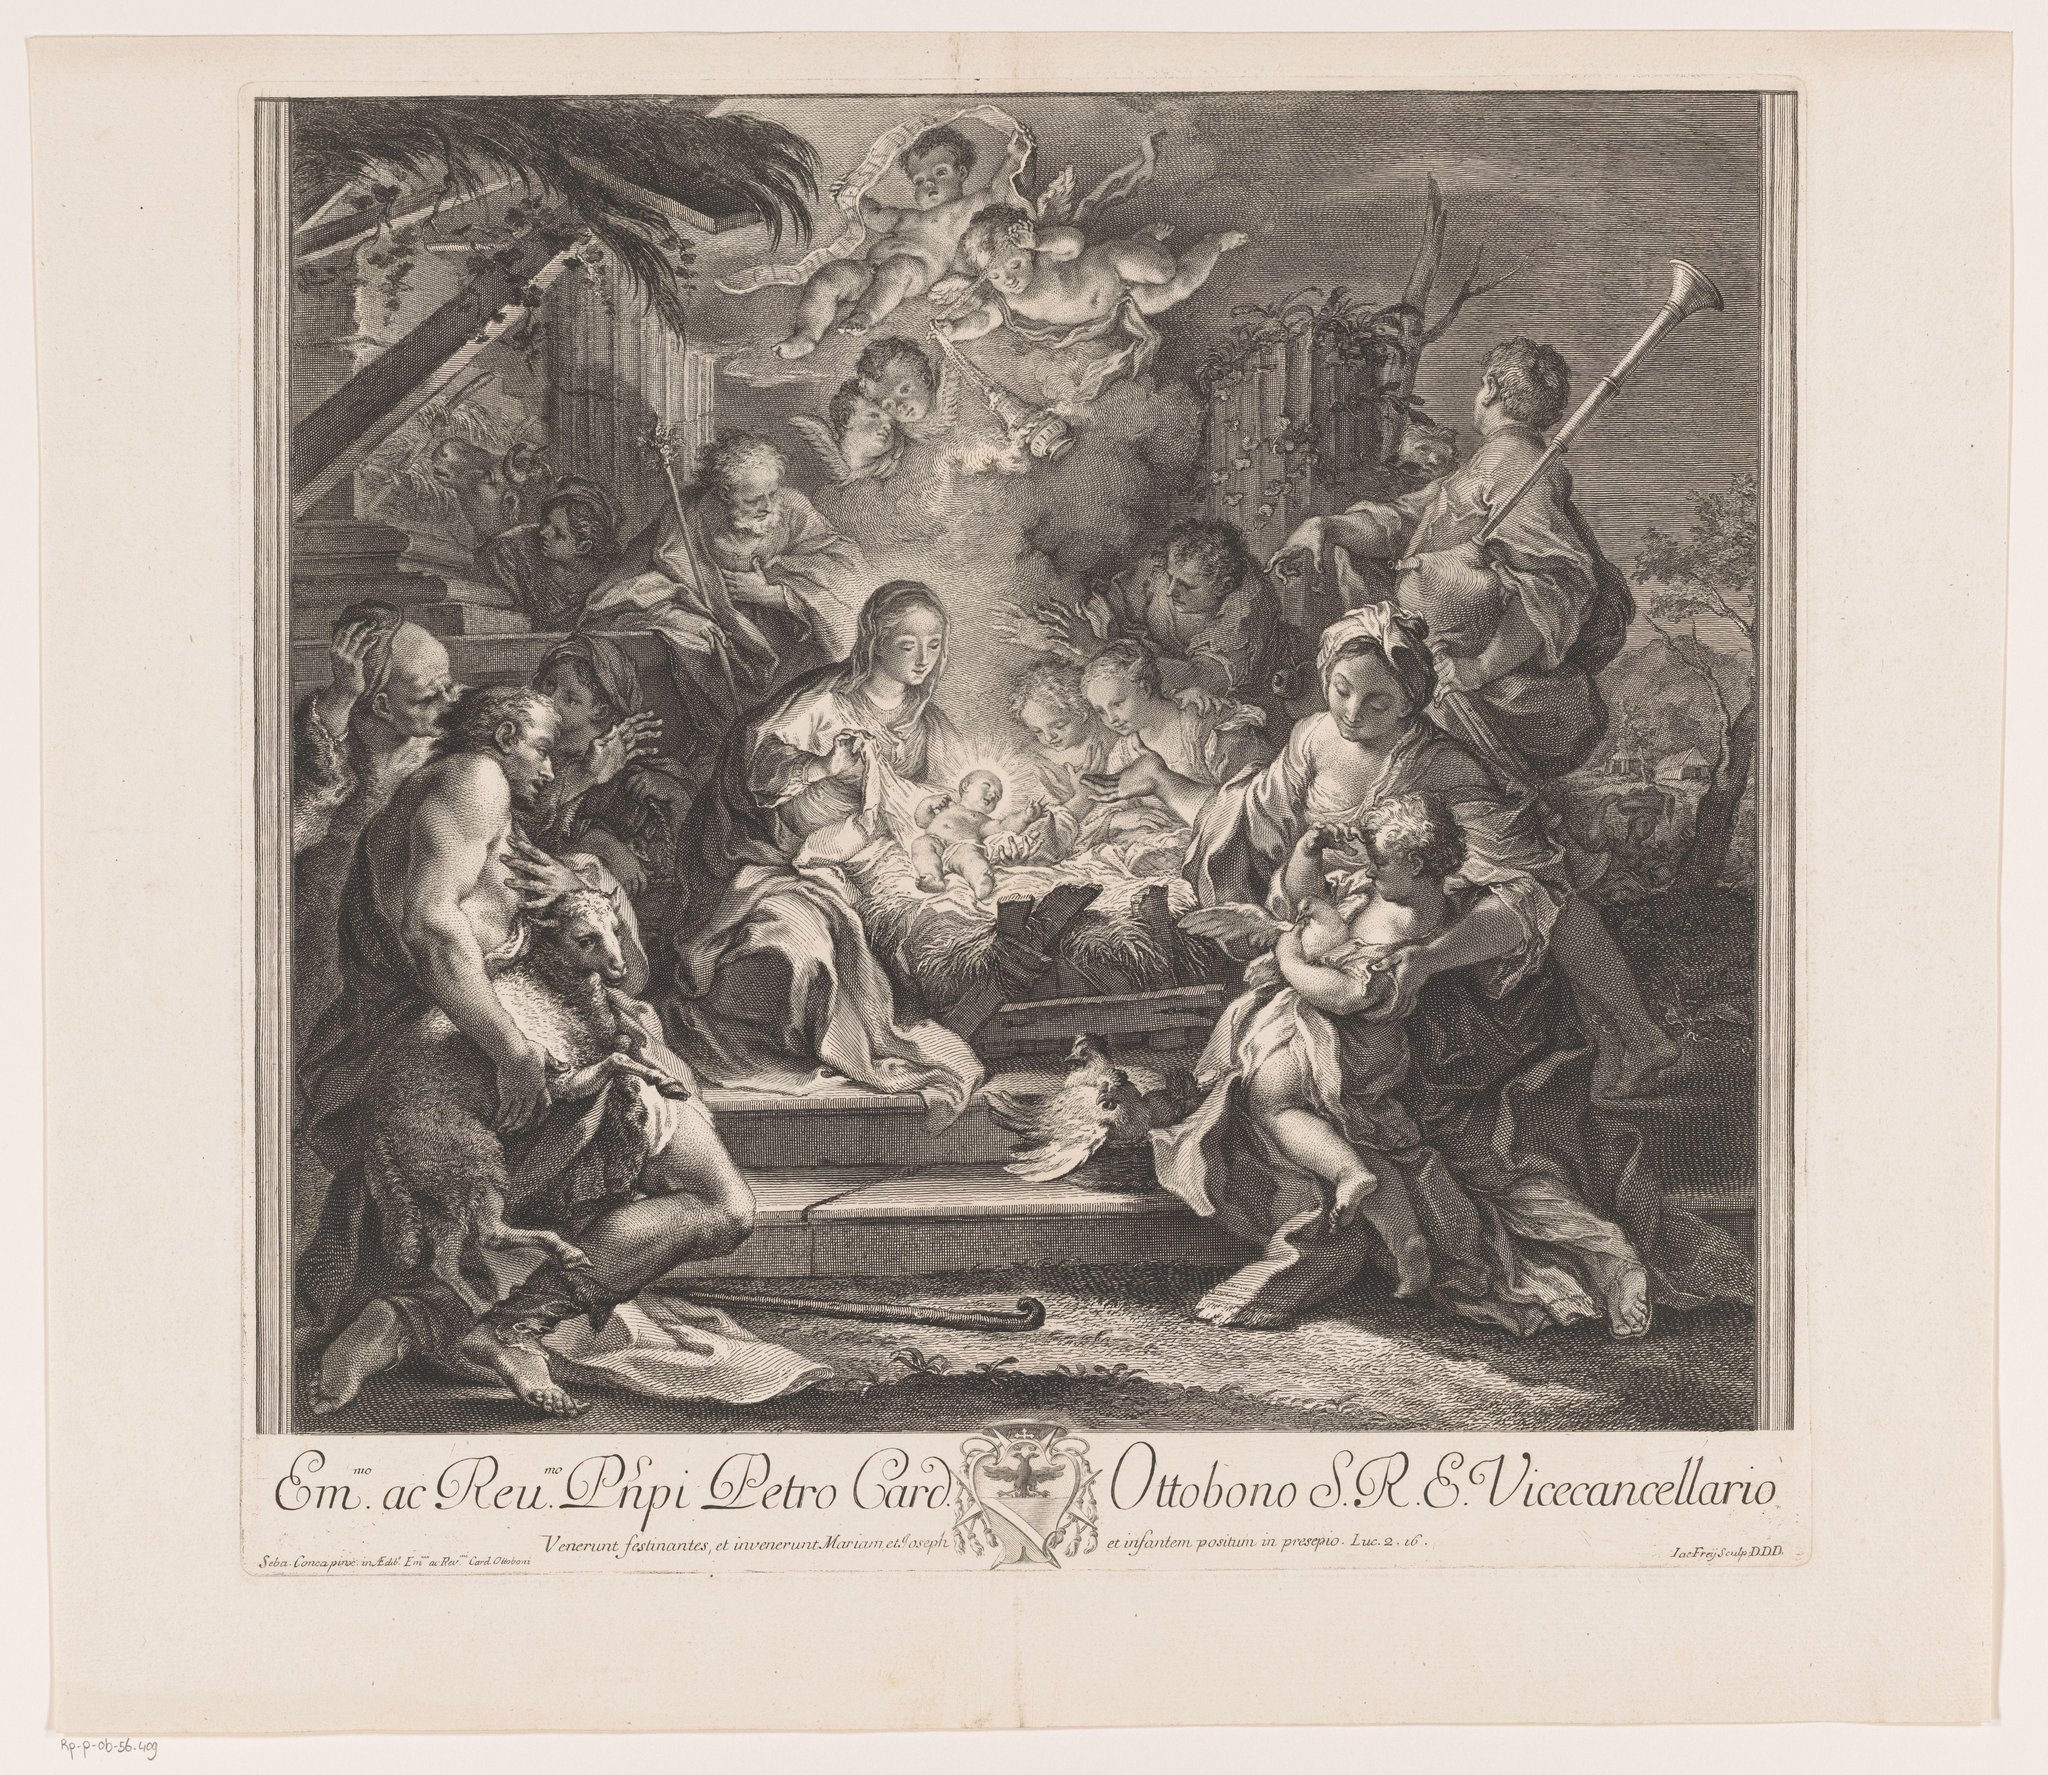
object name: print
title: Aanbidding door de herders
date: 1720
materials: paper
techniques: engraving, etching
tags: adoration of the christ-child ~ christ's birth, armorial bearing, heraldry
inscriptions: collector's mark: Lugt 2165